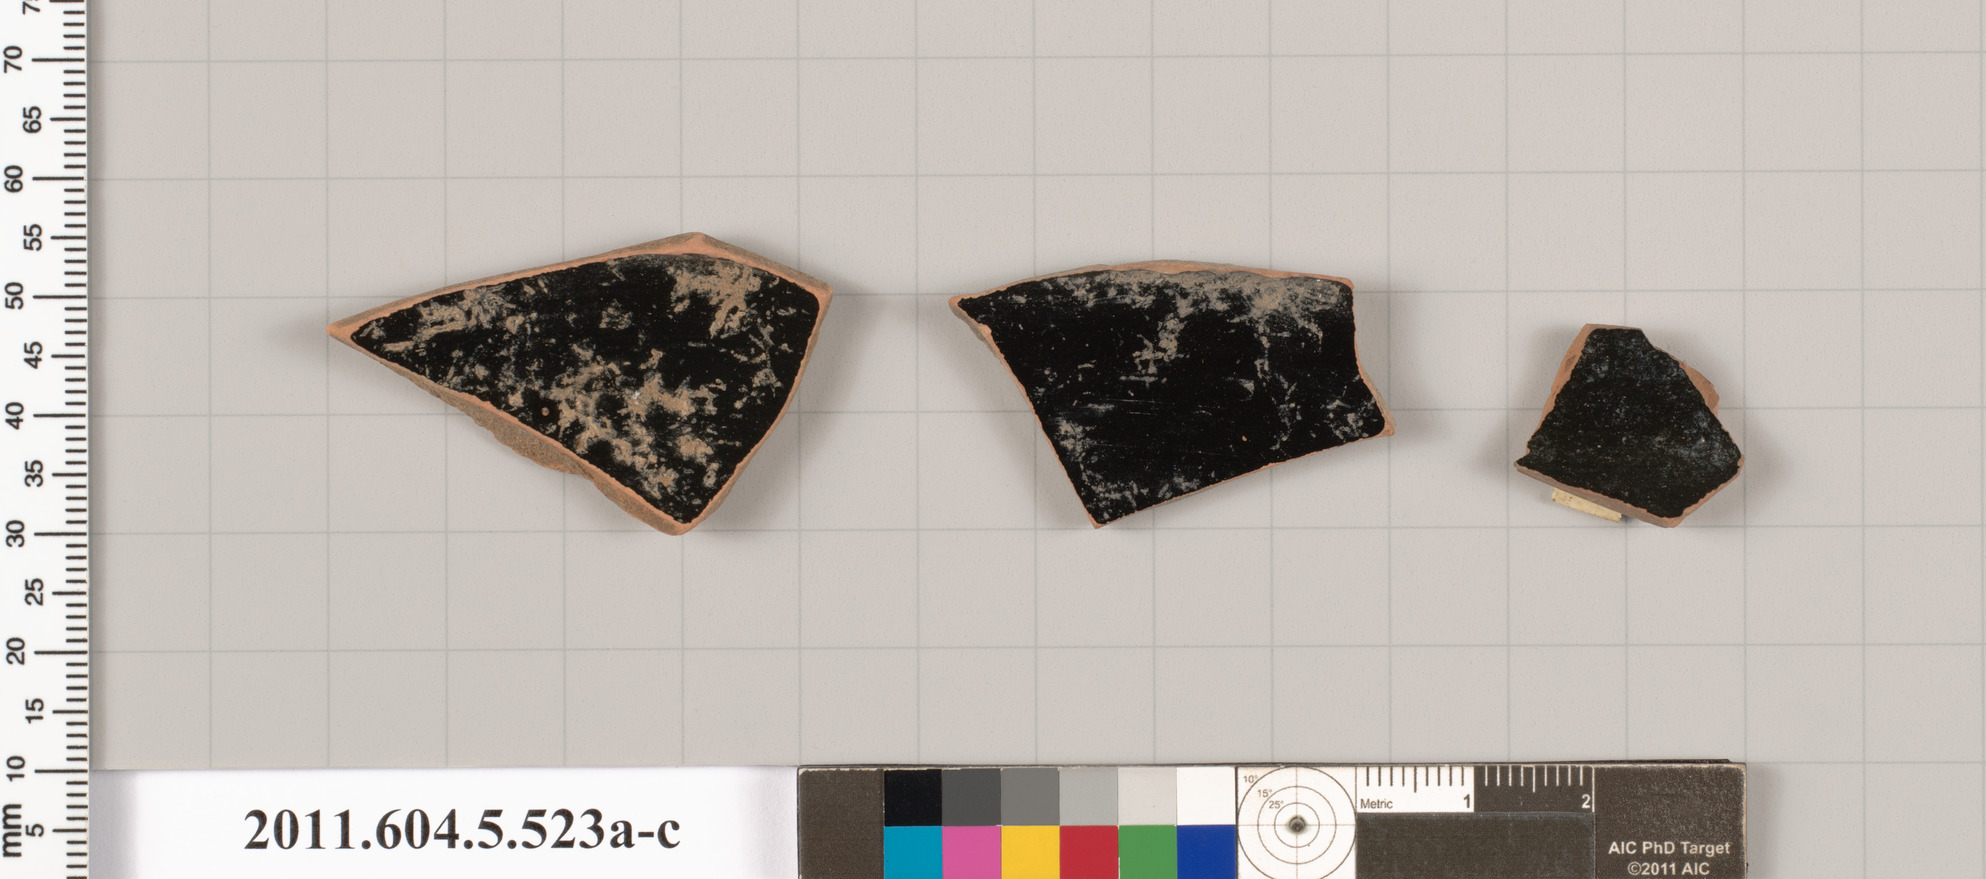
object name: kylix fragment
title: Terracotta fragments of kylikes (drinking cups)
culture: greek, attic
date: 600-401 BCE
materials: terracotta